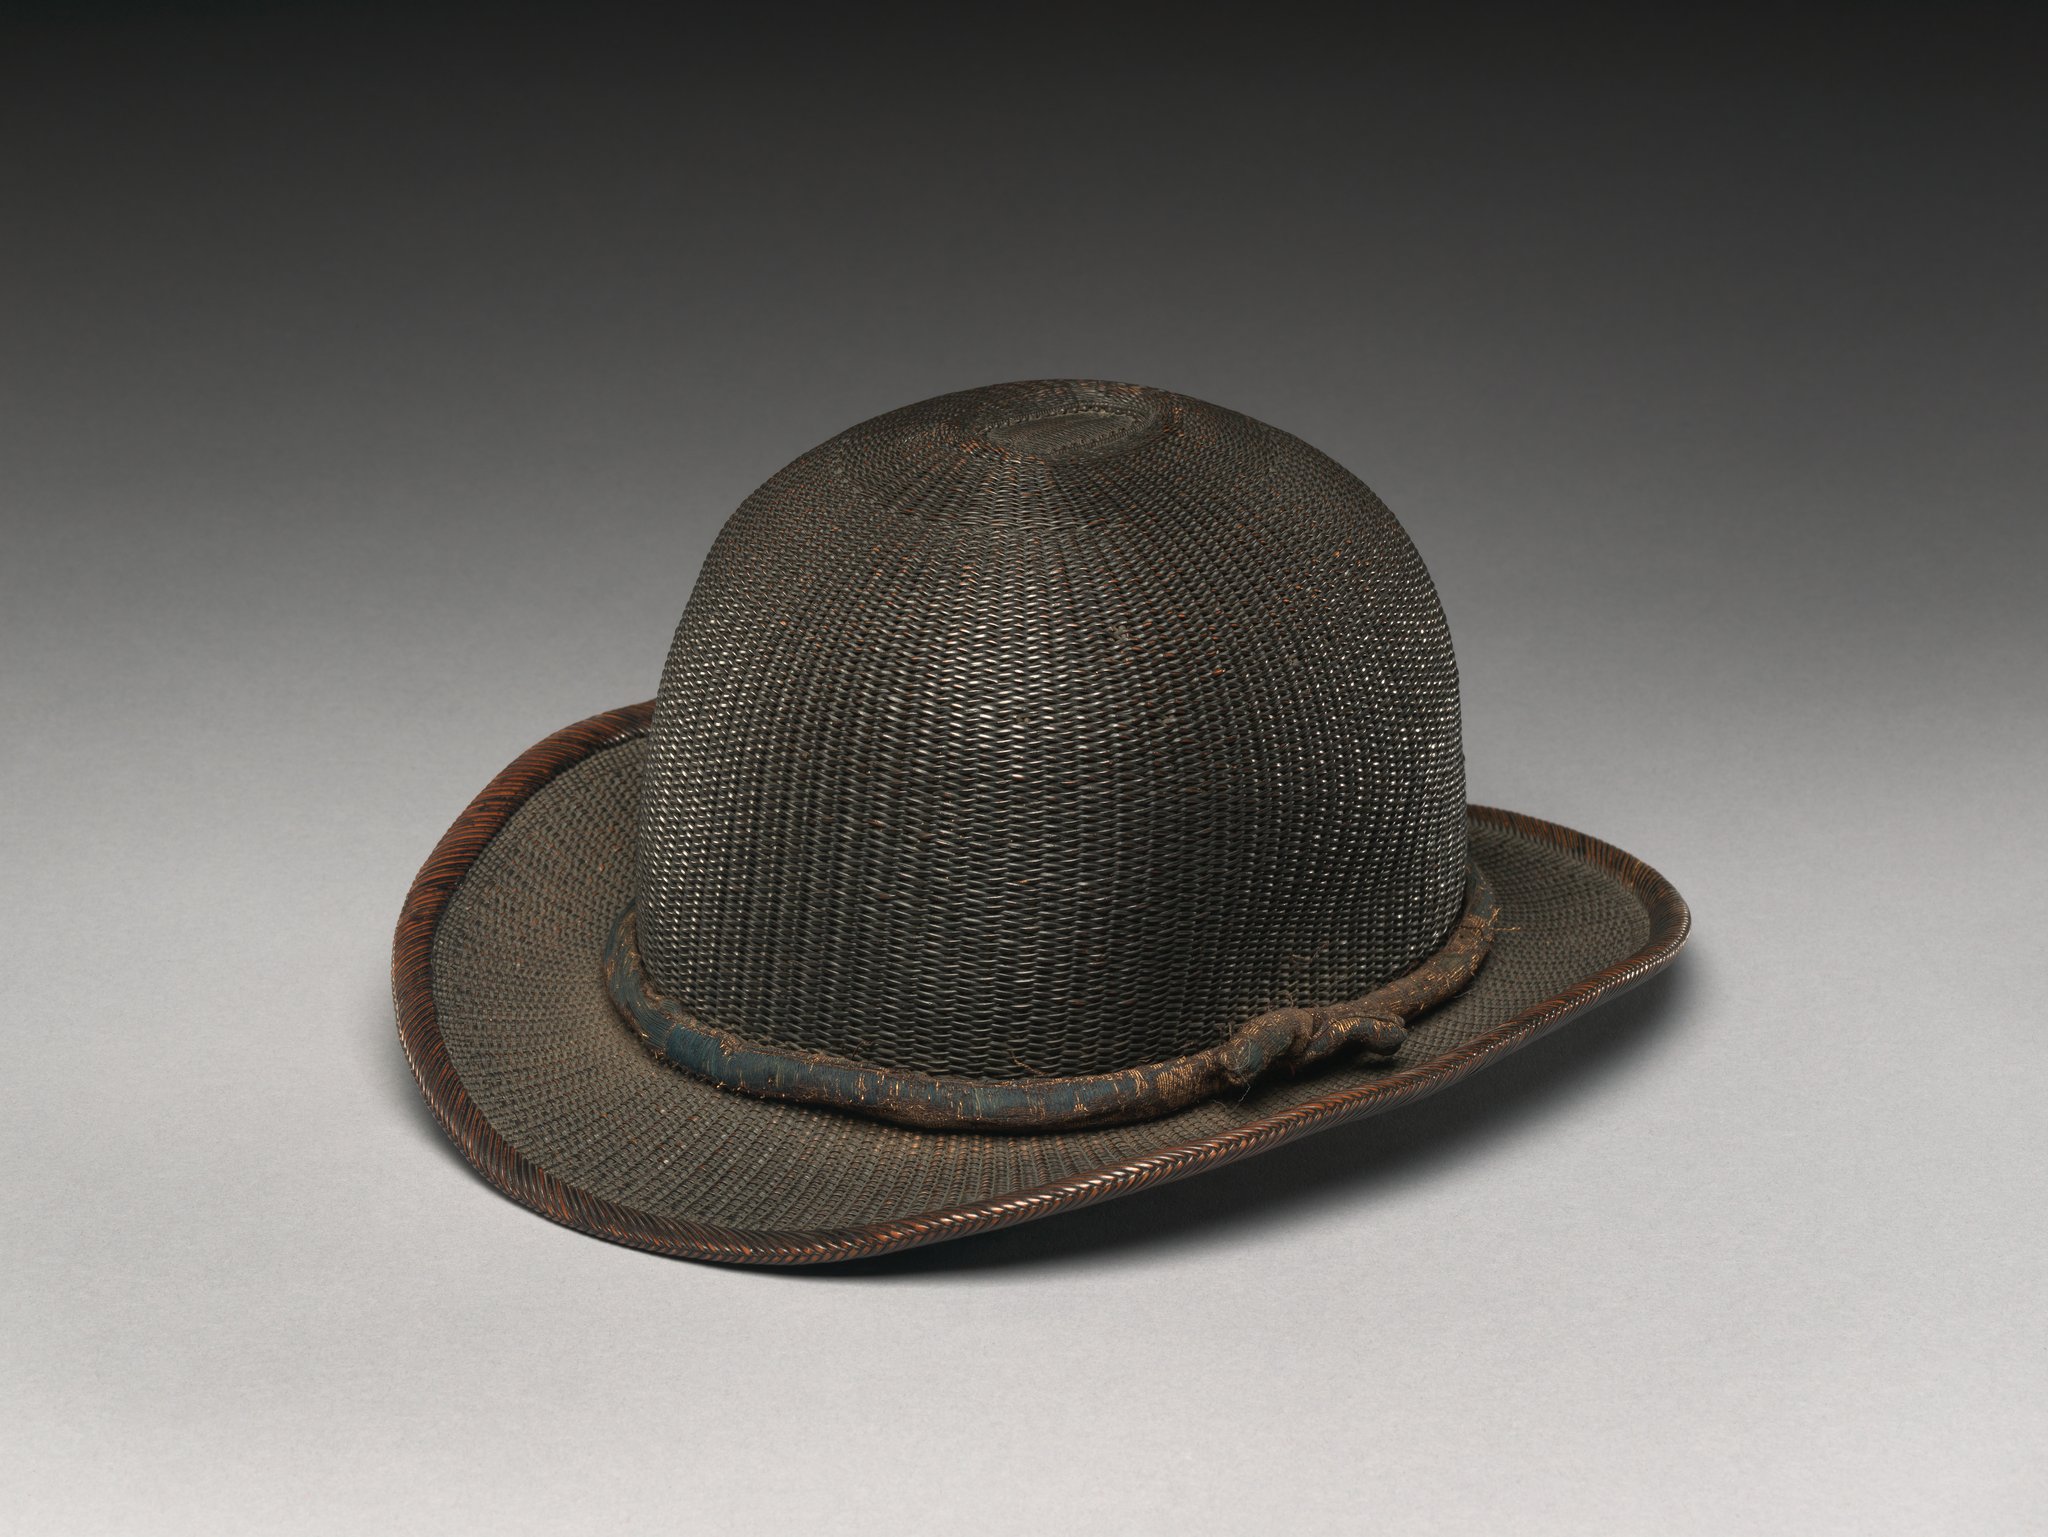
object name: hat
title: Bowler Hat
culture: japanese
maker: hayakawa shōkosai i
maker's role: artist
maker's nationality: japanese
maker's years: 1815-1897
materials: bamboo, rattan, silk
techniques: brocade